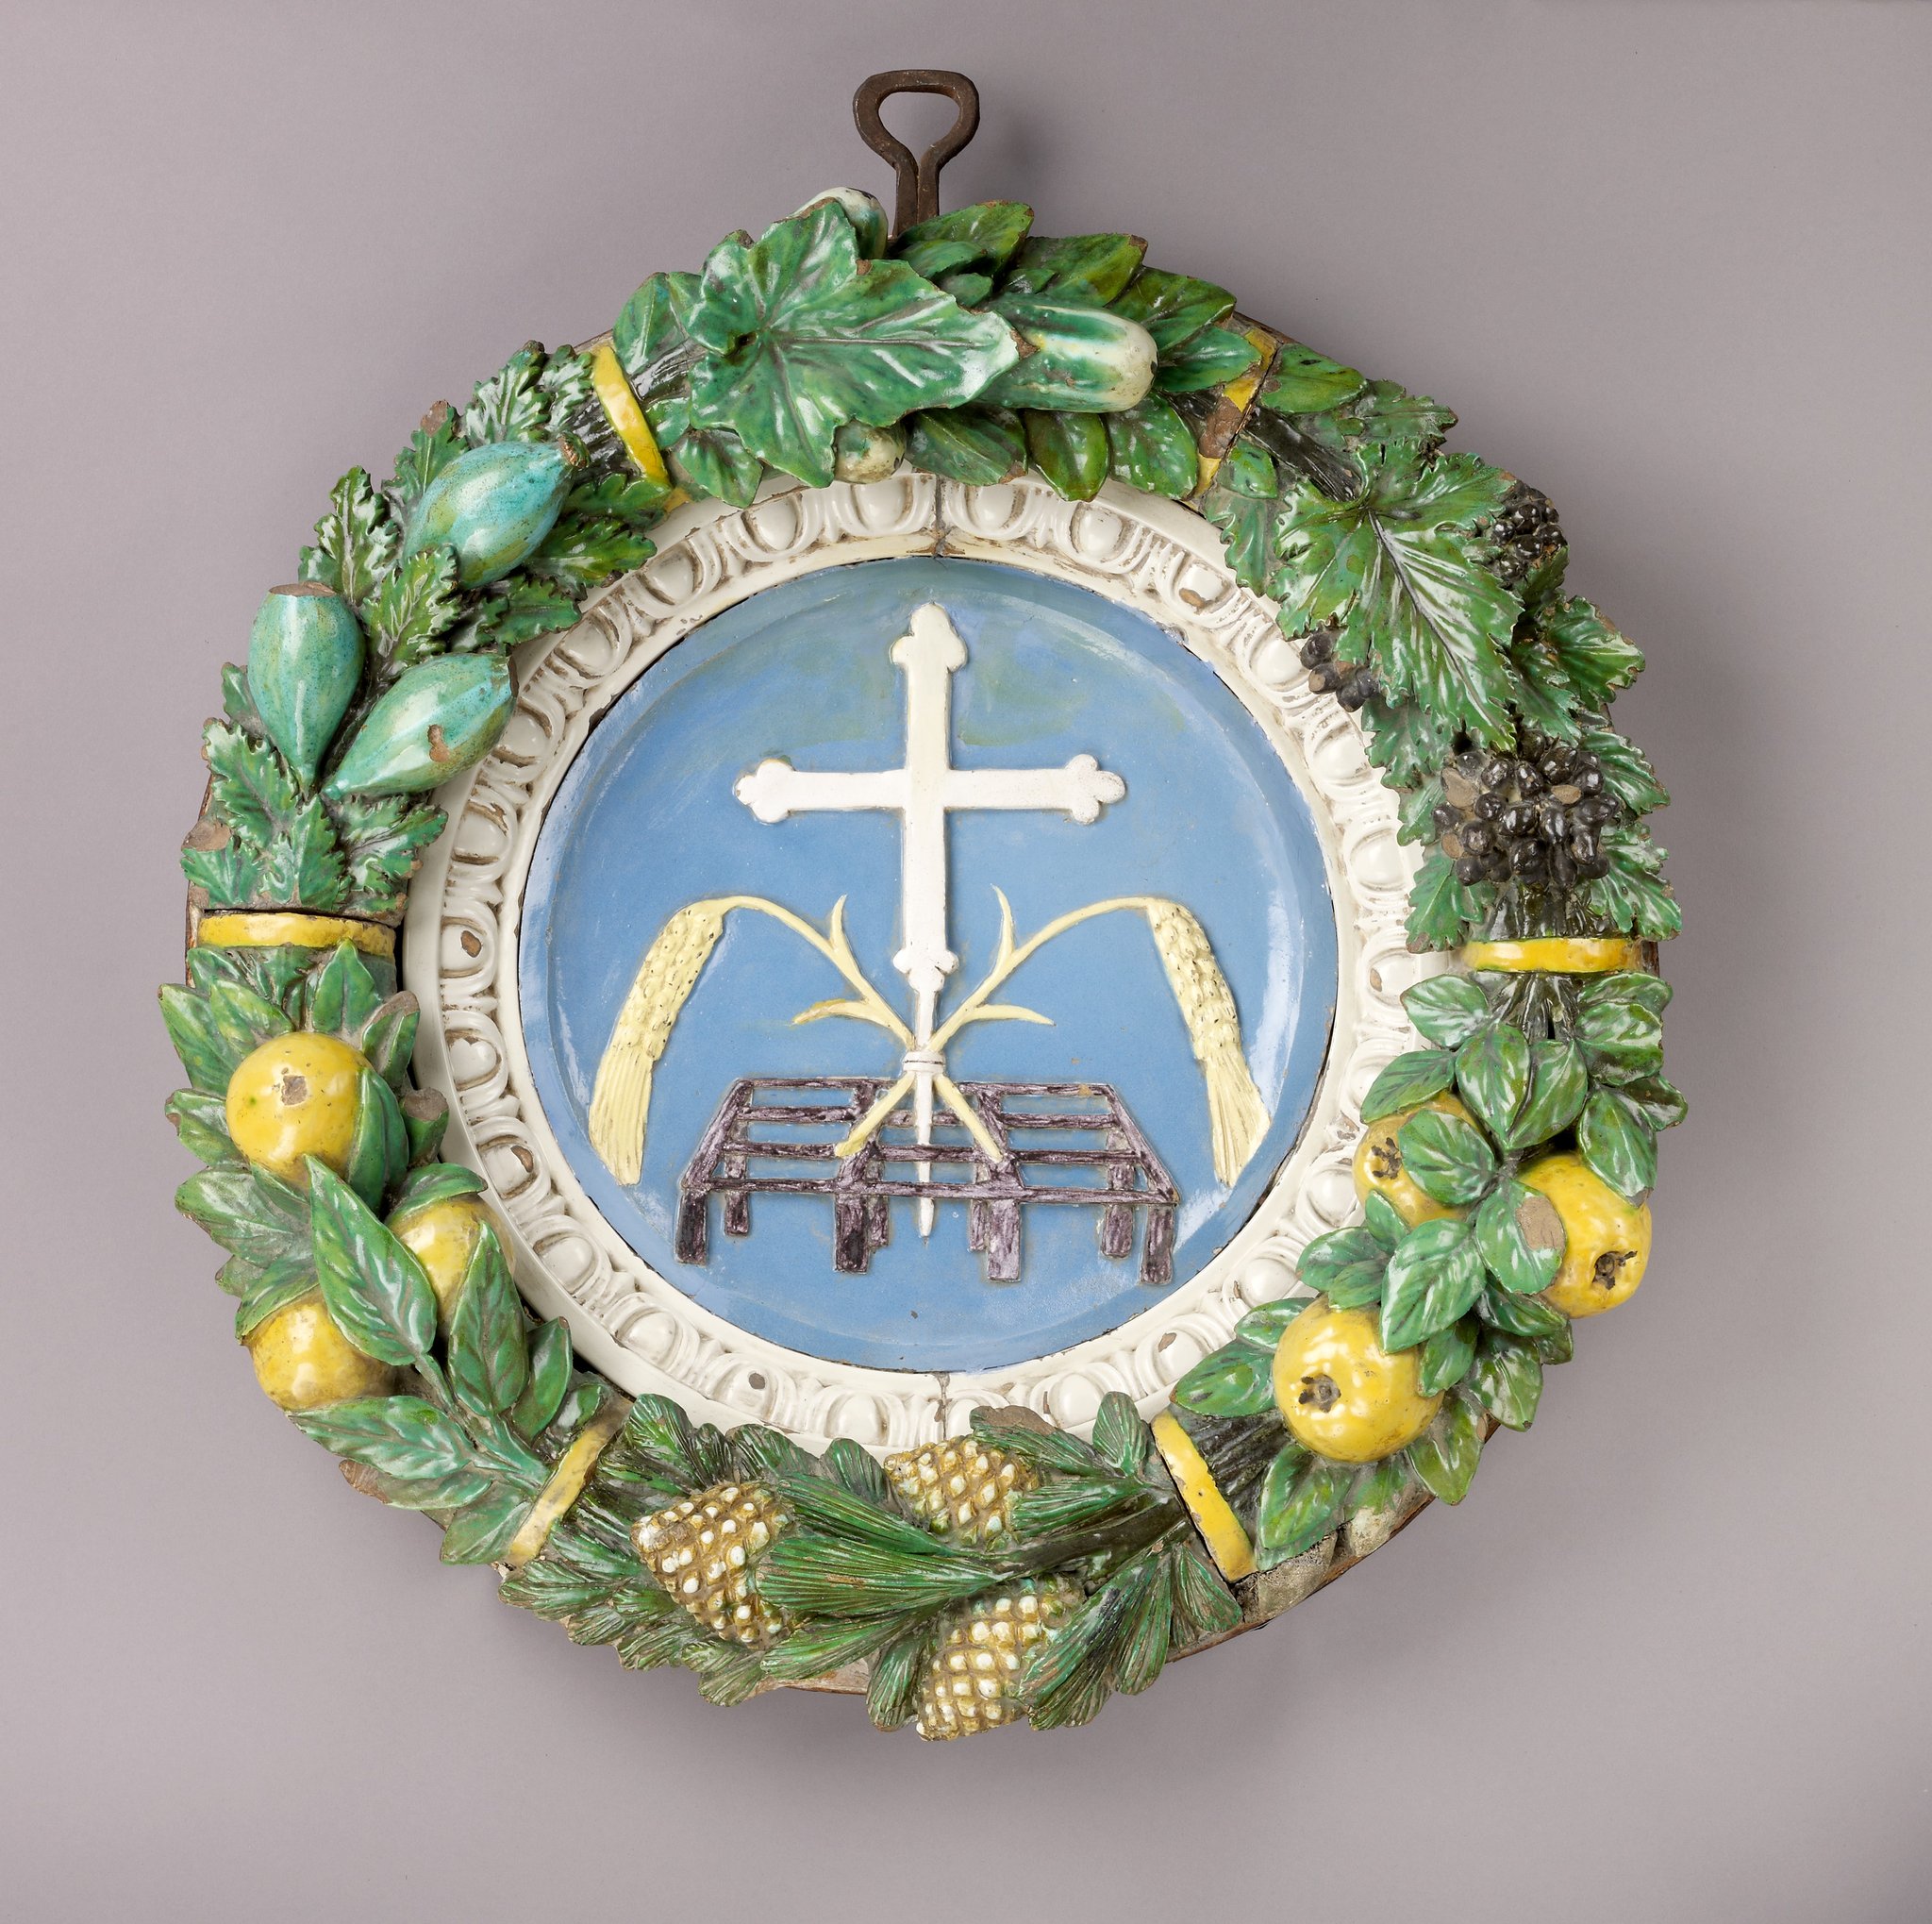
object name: tondo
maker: giovanni della robbia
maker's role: artist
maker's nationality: italian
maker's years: 1469-1530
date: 1500-1520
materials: terracotta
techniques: glazing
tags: cross